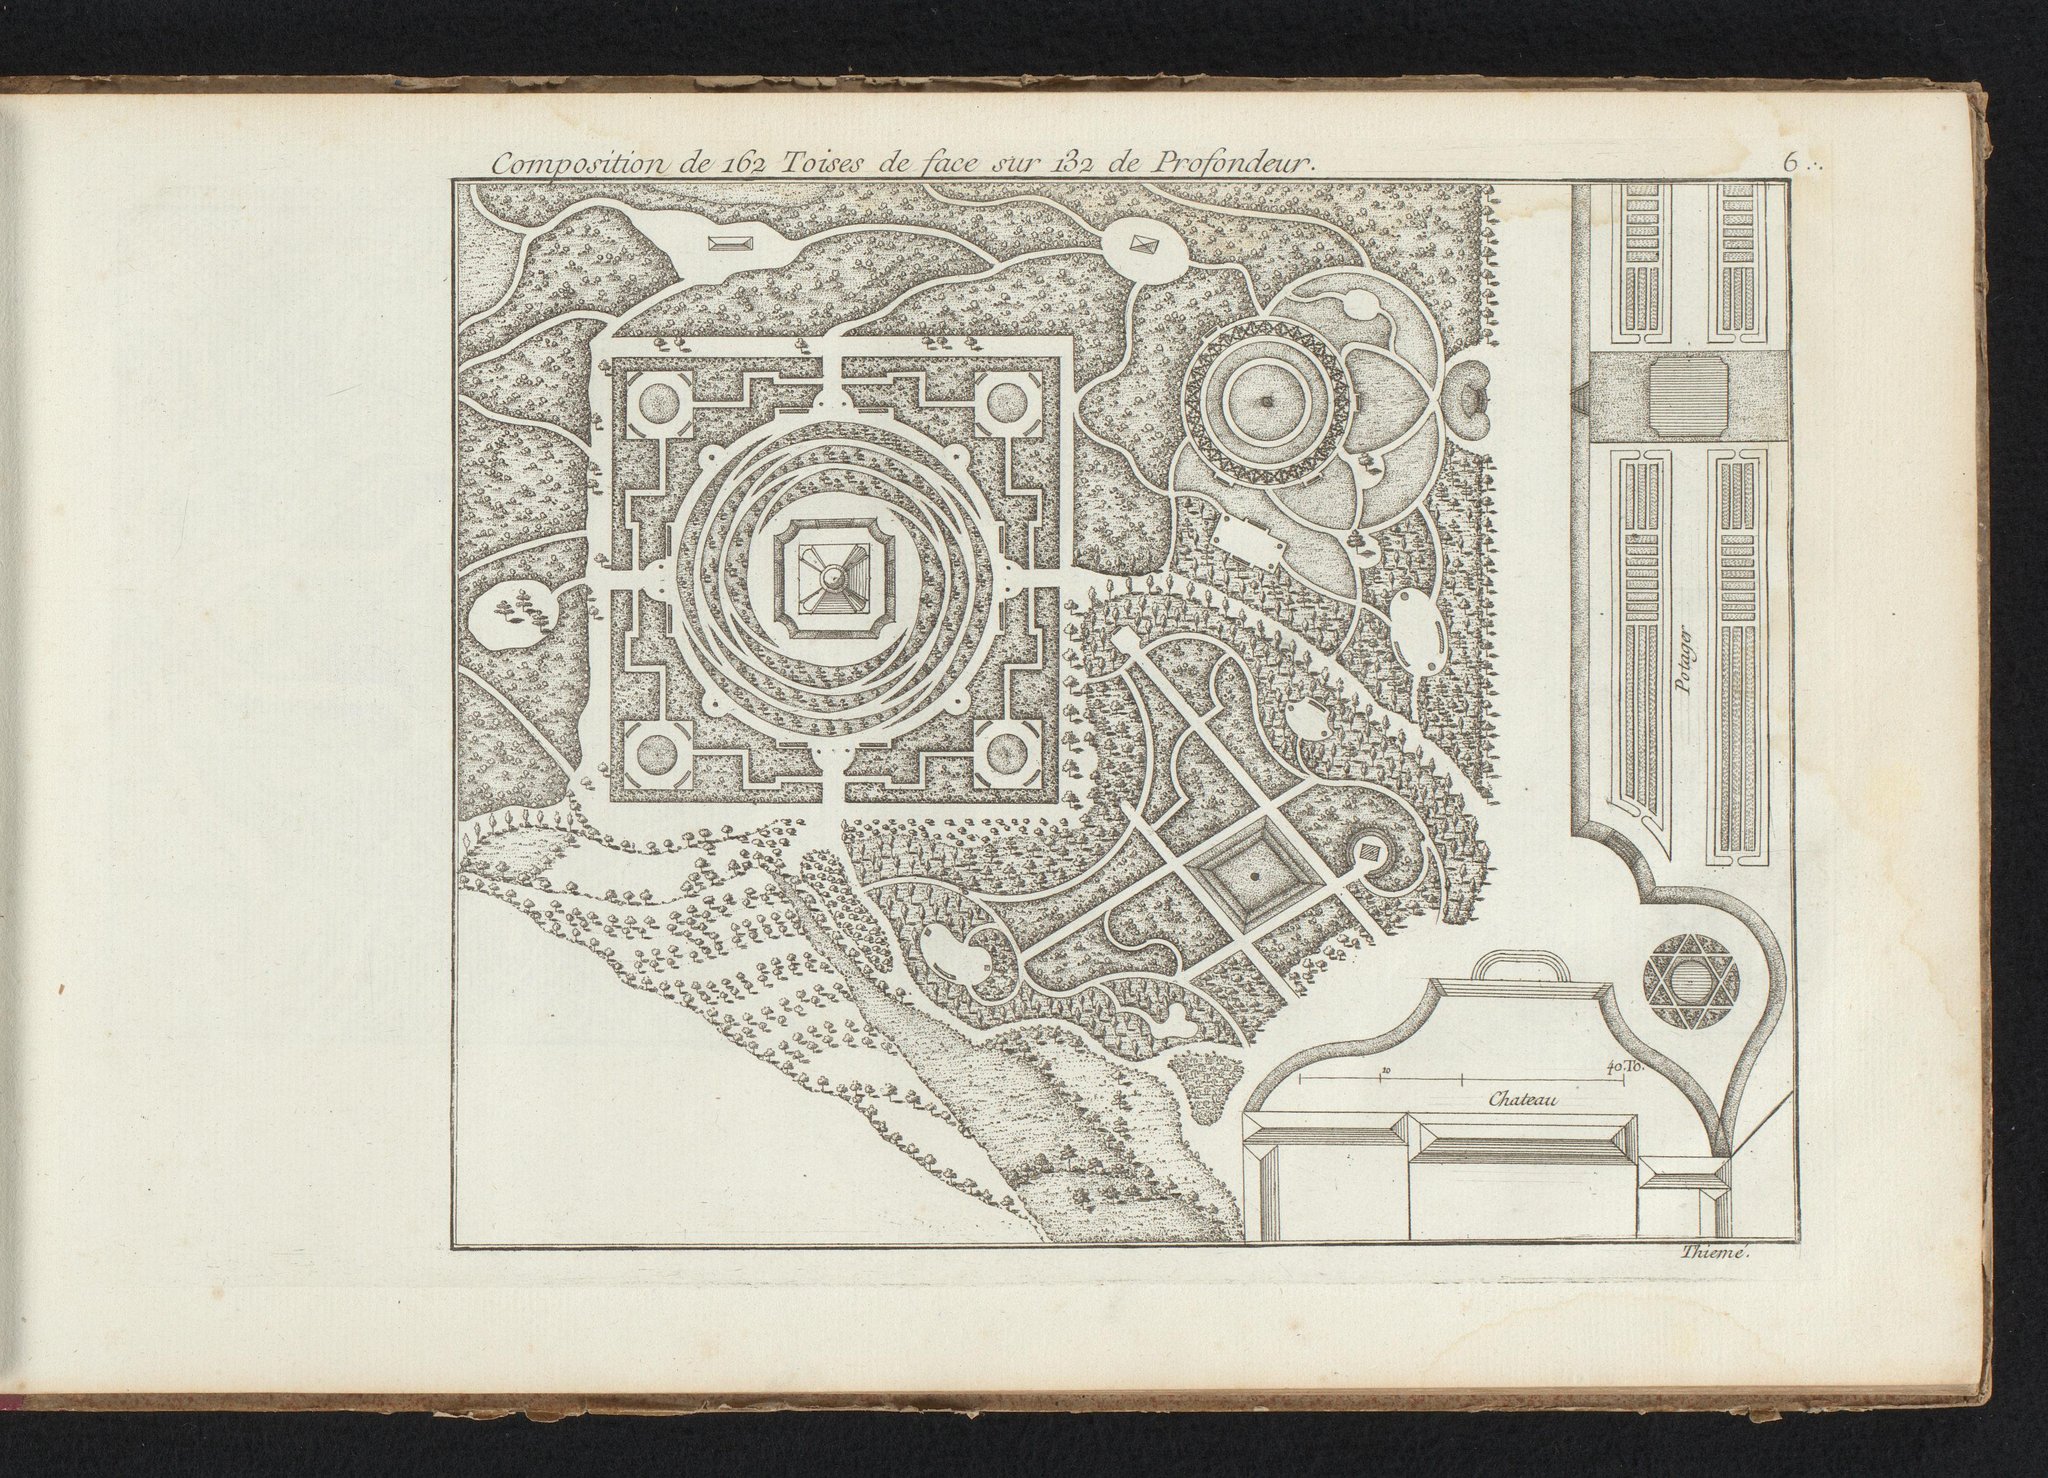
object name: print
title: Jardins anglo-chinois à la mode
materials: paper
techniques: engraving, etching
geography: paris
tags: plan, map of garden, lay-out of garden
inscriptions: collector's mark: Lugt 2760, collector's mark: Lugt 2228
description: De serie 'Jardins anglo-chinois à la mode' verscheen in totaal in 21 zogeheten 'cahiers' (afleveringen). De huidige prent komt uit het derde 'cahier'. Het Rijksmuseum Amsterdam bezit drie banden met daarin in totaal zes 'cahiers' van deze reeks. In de documentatie wordt verwezen naar een in de bibliotheek van het Rijksmuseum Amsterdam aanwezige facsimile van het complete werk.